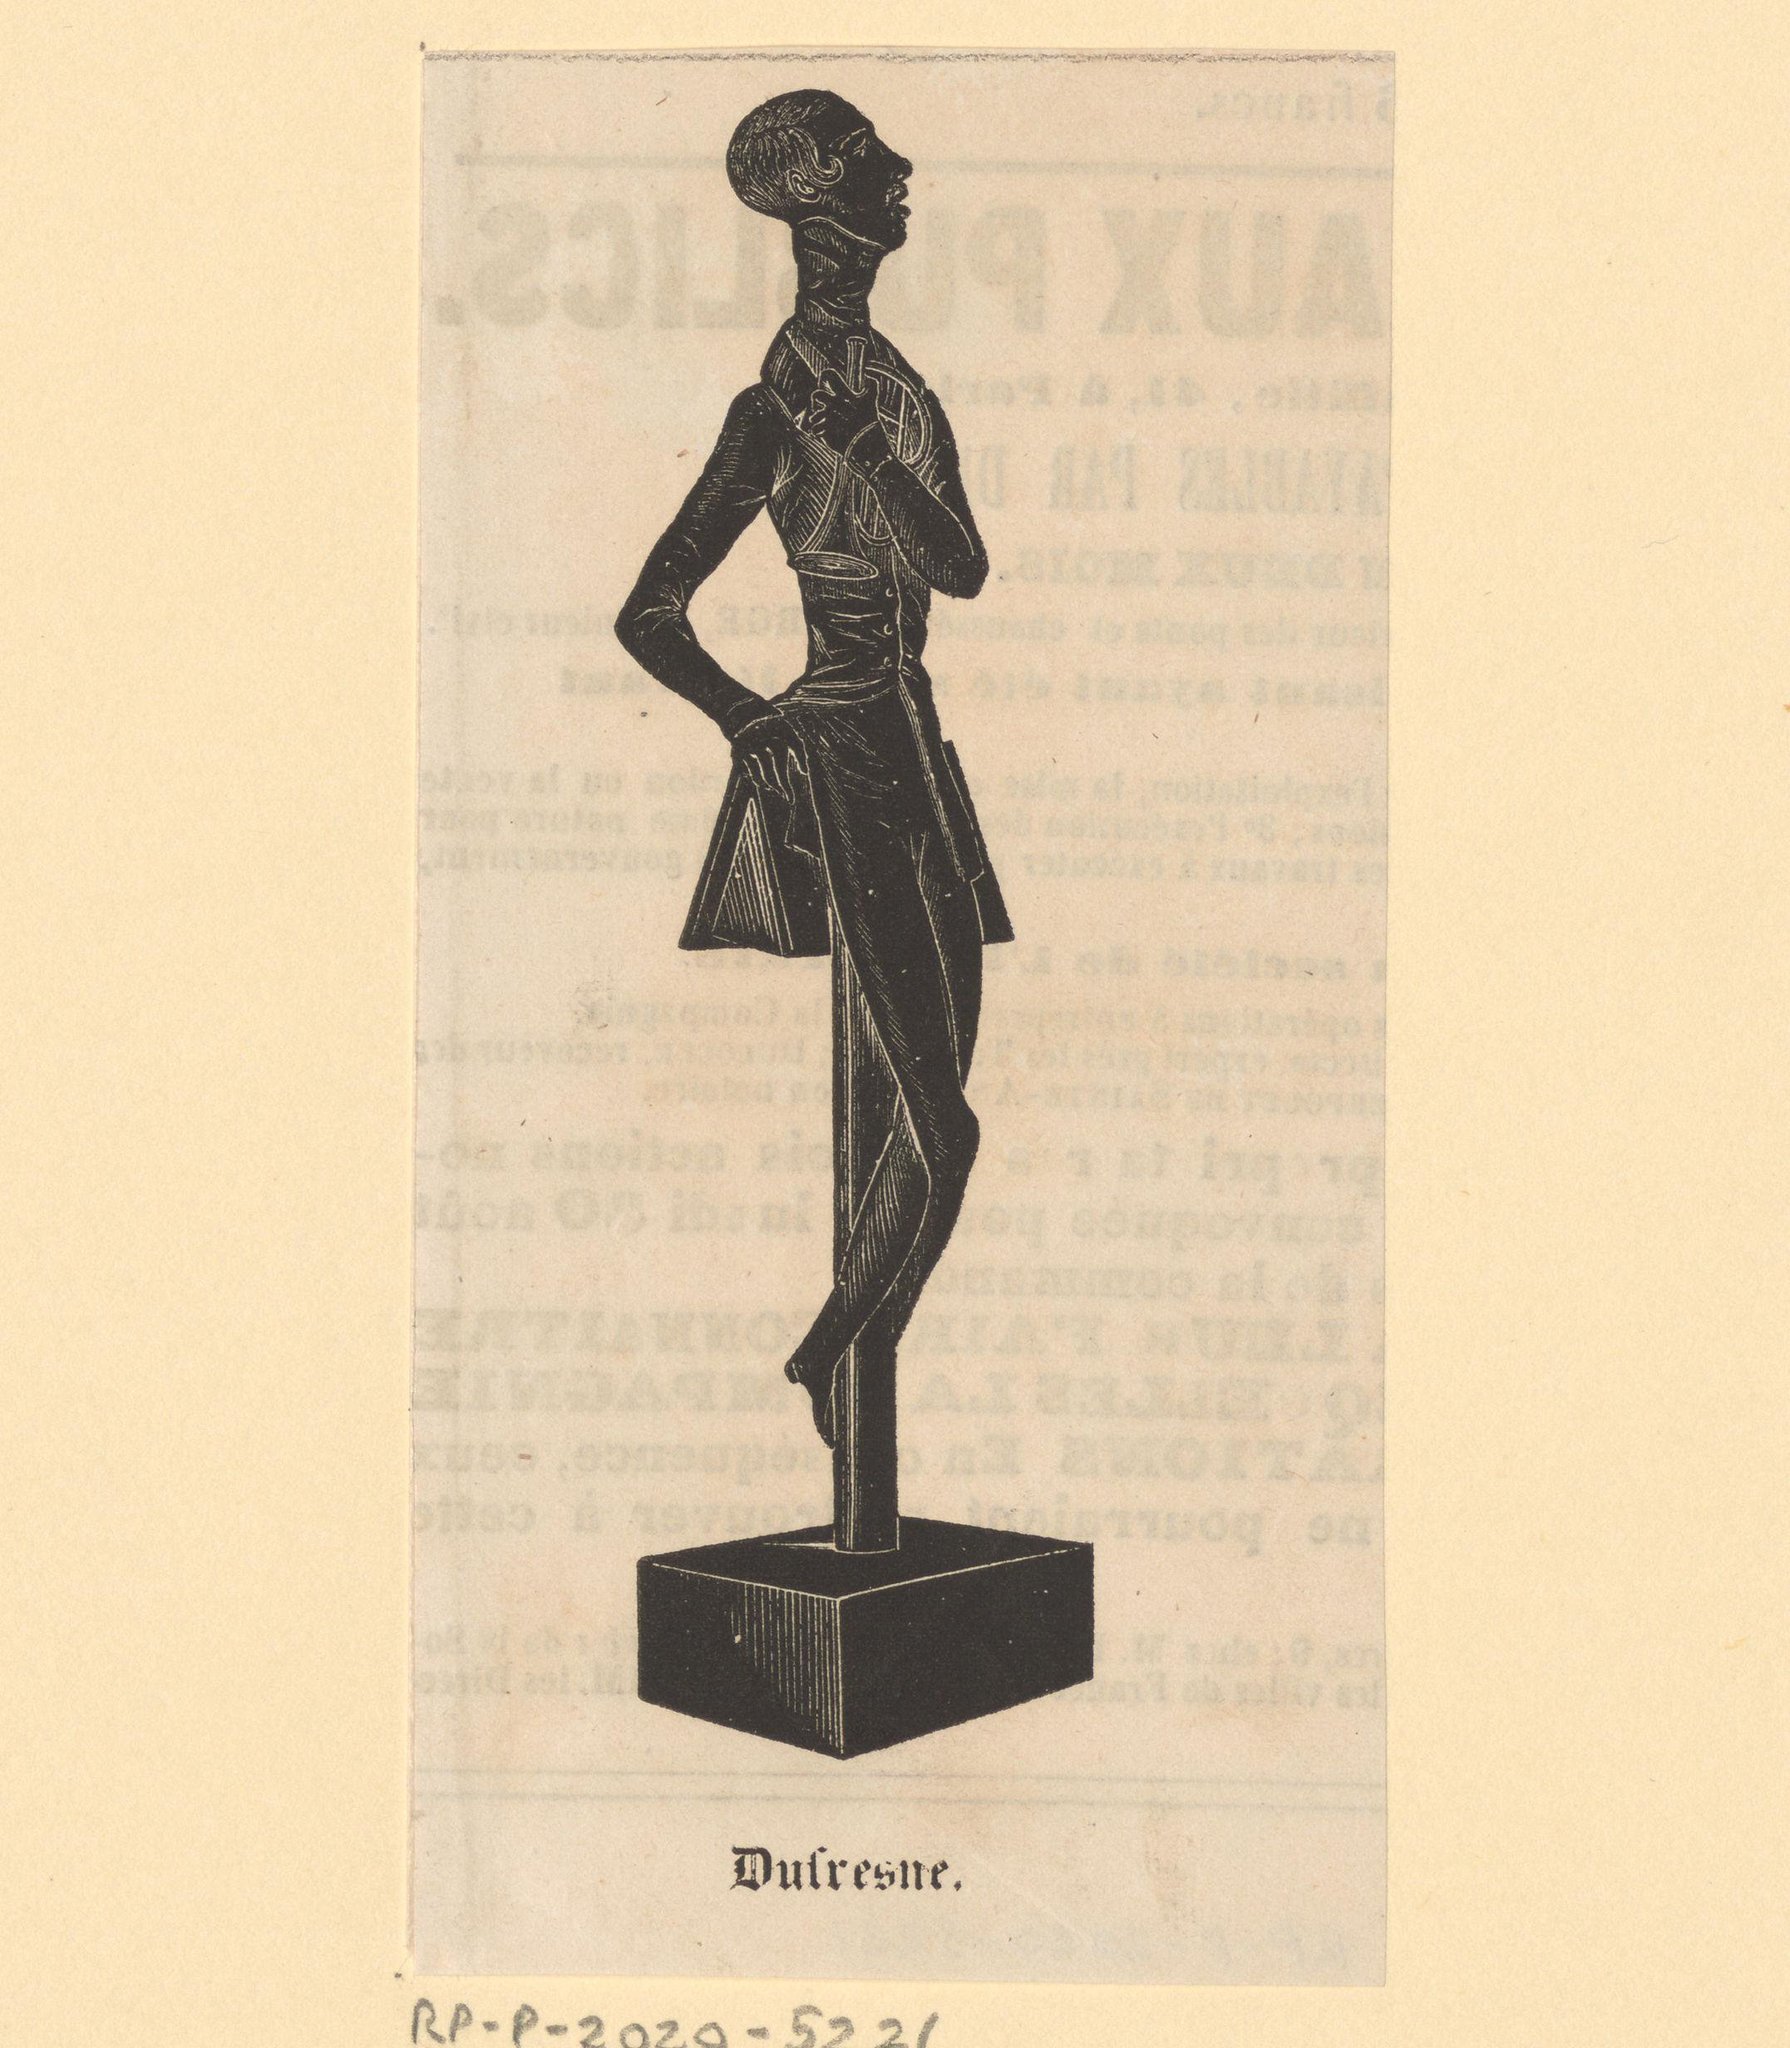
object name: print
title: Portret van Alfred Dufresne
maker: Anonymous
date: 1839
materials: paper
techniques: letterpress printing, engraving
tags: paris, historical persons, composer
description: Prent met tekst op verso gebruikt in: Musée Dantan. Galerie des charges et croquis des célébrités de l'époque (...). Parijs: Henri Delloye, 1839.